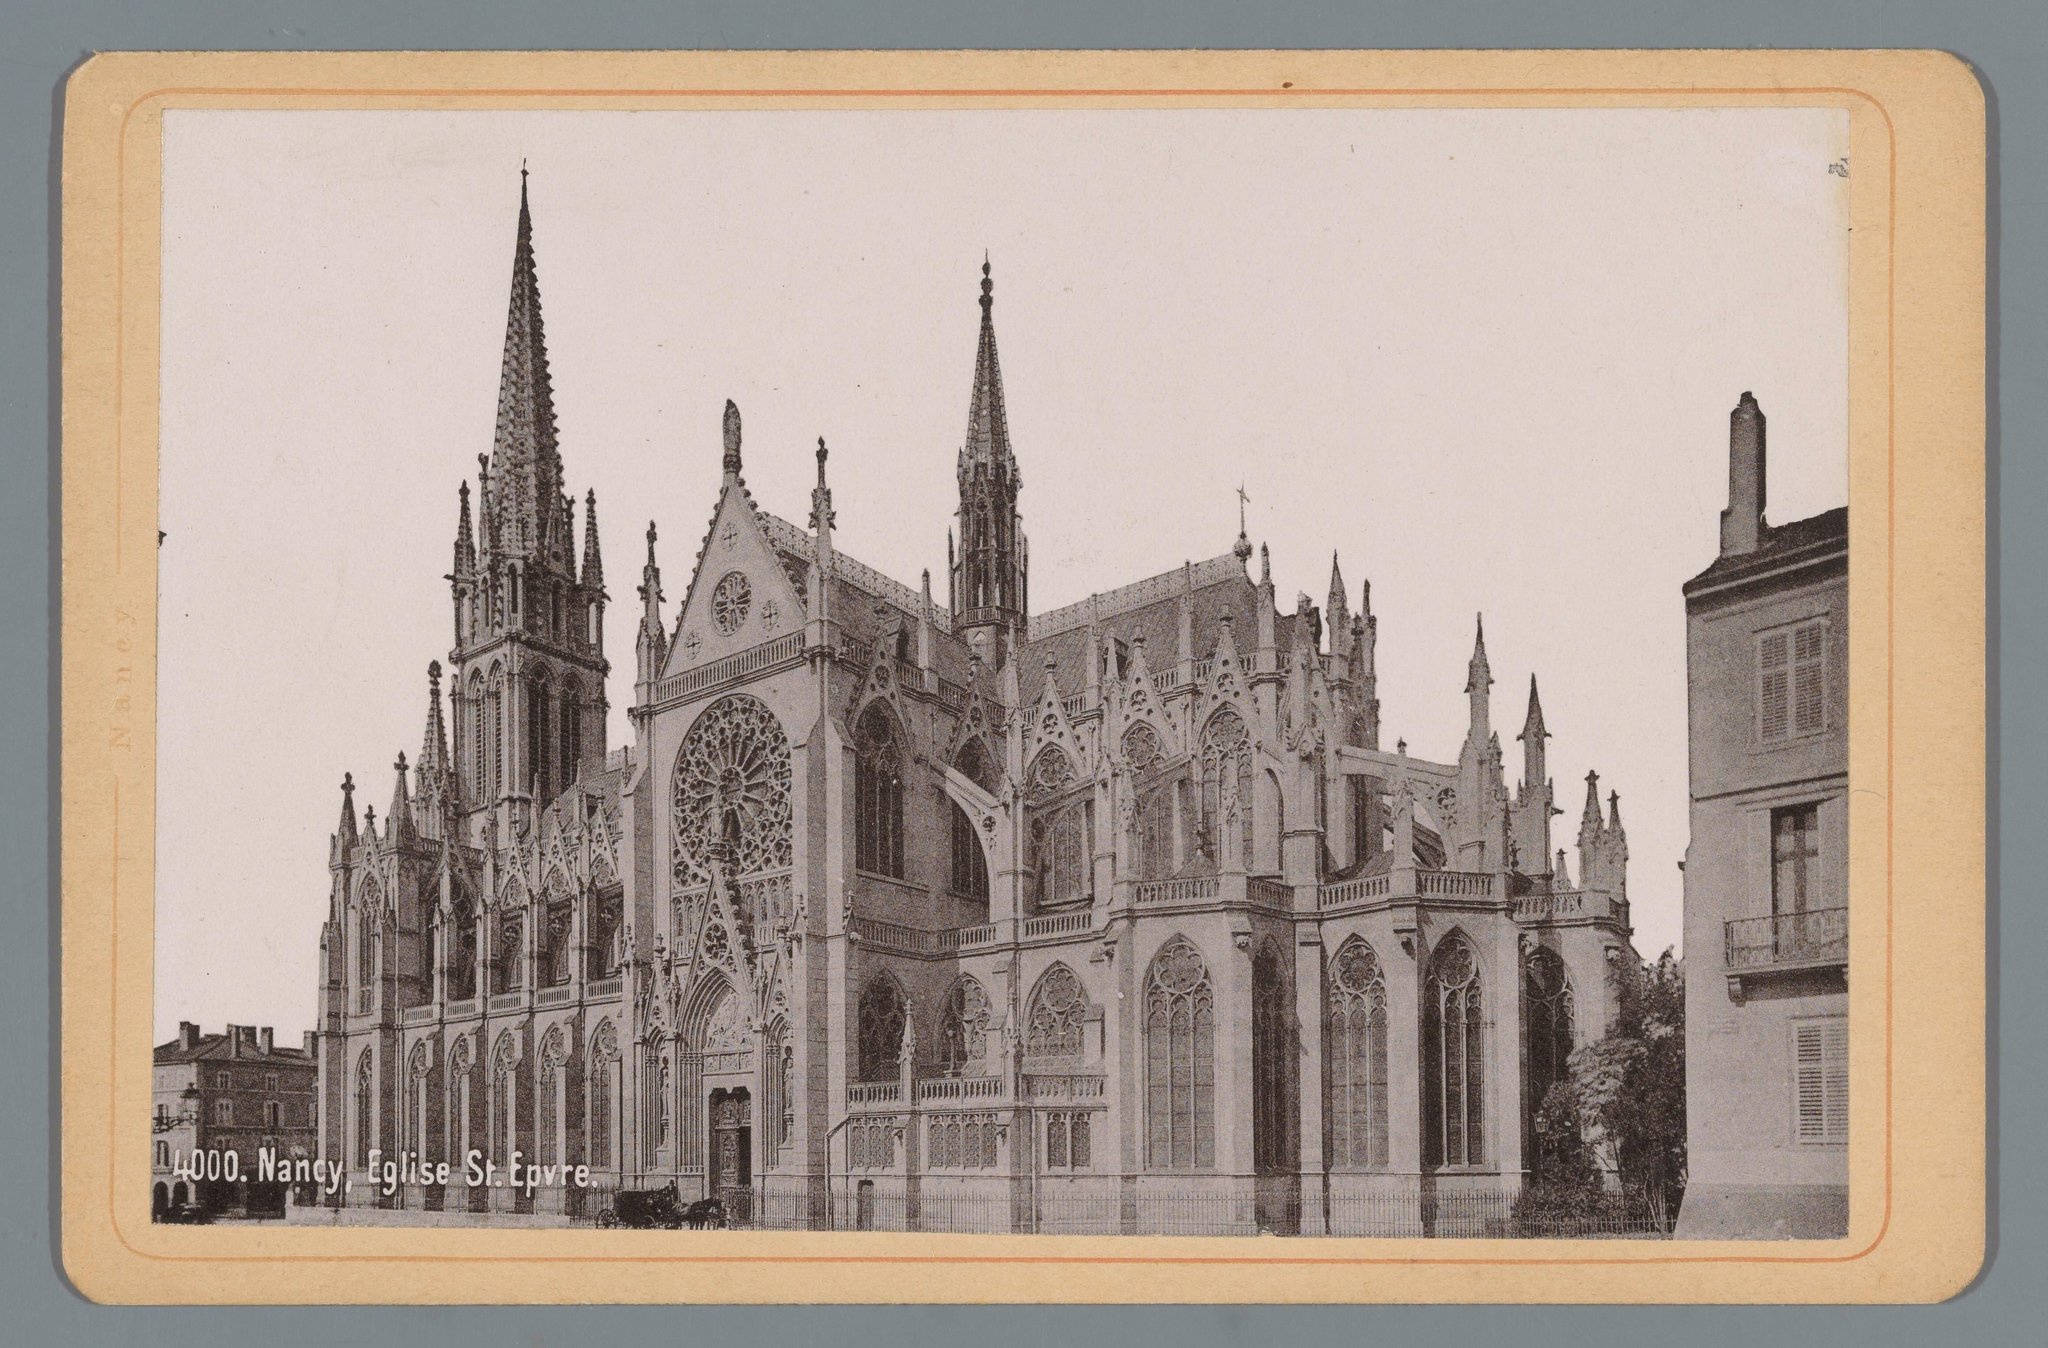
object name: photomechanical print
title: Eglise St. Epvre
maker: Anonymous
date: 1875-1930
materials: cardboard, paper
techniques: photograph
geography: nancy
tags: church (exterior), façade (of house or building)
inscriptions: number: ‘4000.’